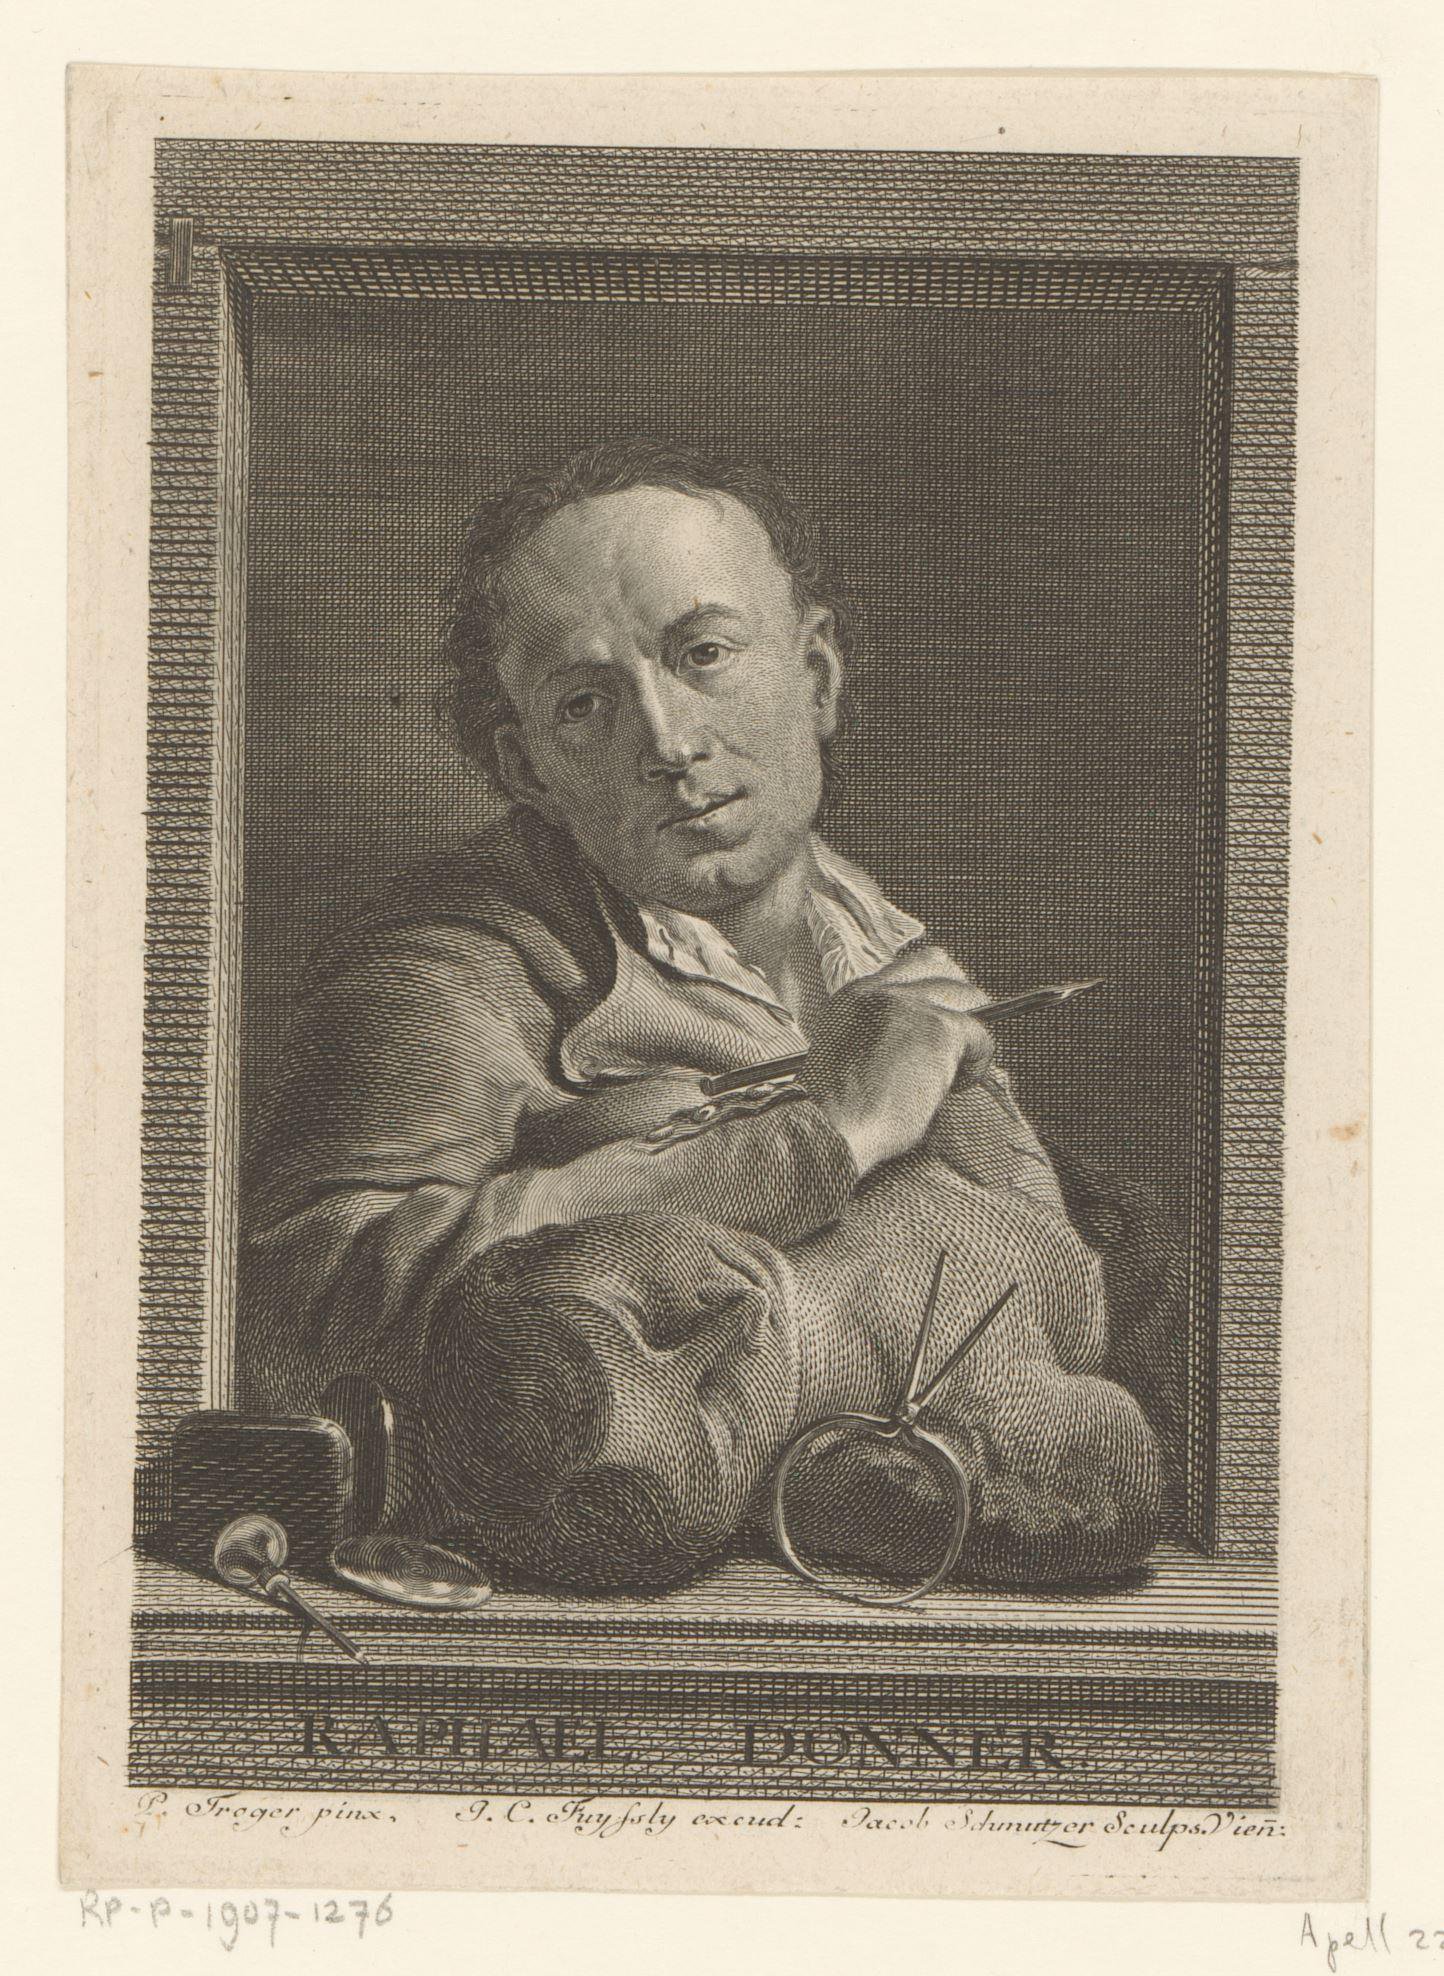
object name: print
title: Portret van George Raphael Johann Donner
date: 1743-1811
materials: paper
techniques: engraving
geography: switzerland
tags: vienna, sculptor at work, historical persons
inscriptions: collector's mark: Lugt 2228